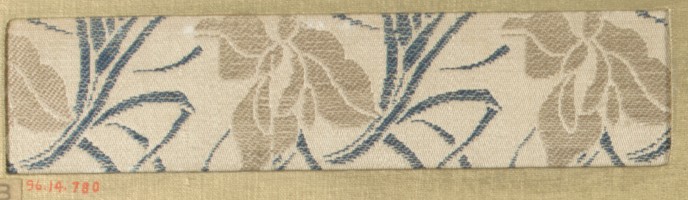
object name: piece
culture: japanese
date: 1701-1900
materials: silk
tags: flowers